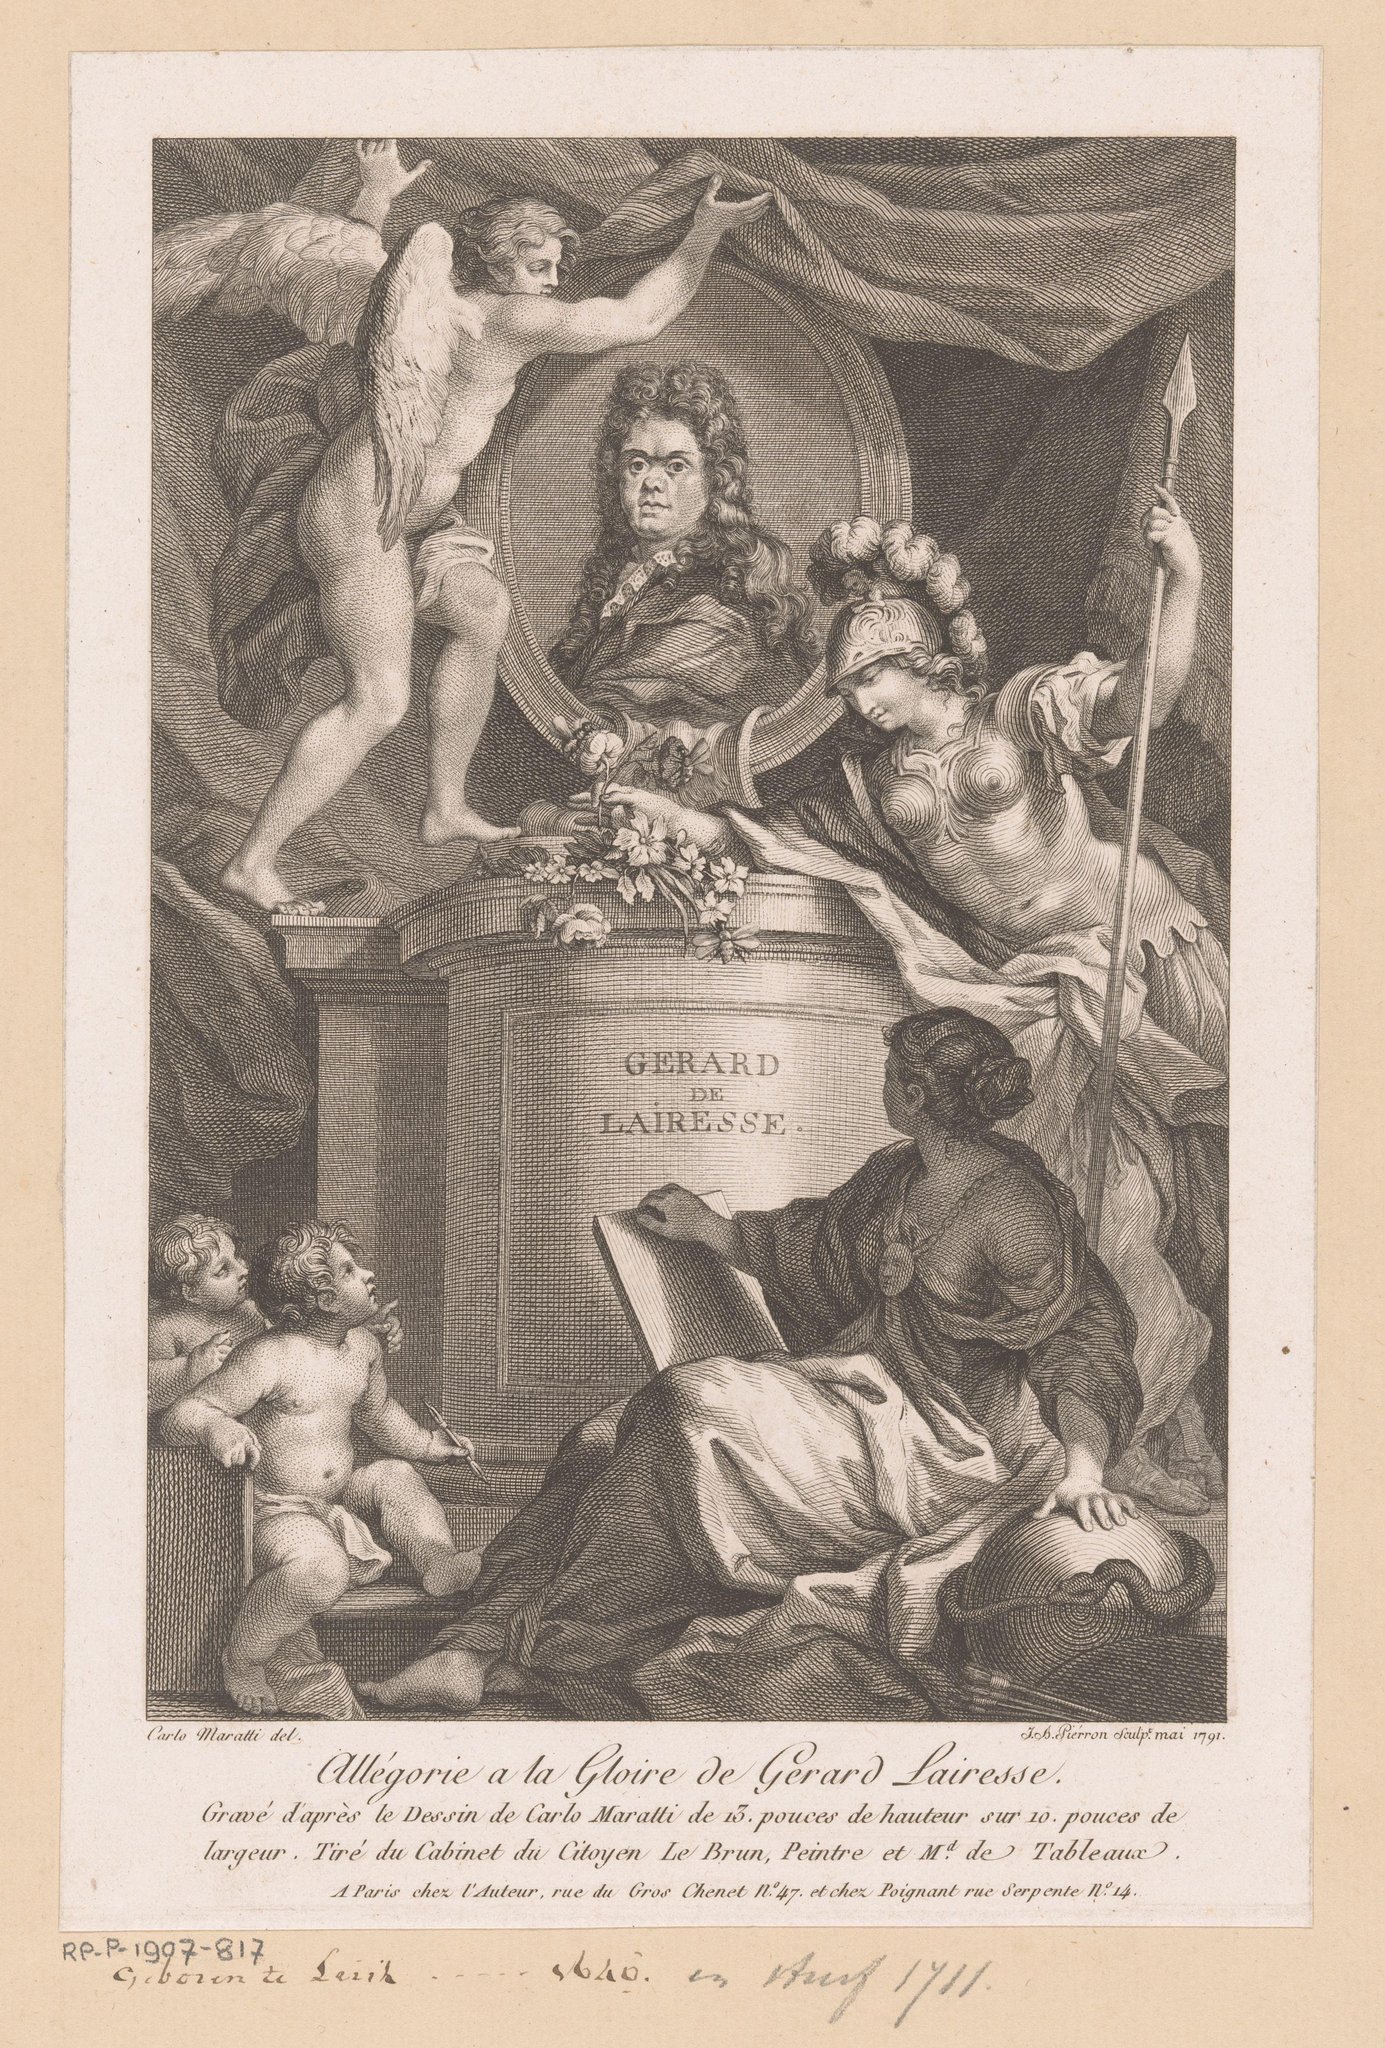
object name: print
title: Allegorie op Gerard de Lairesse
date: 1791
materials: paper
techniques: engraving, etching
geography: paris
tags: liège, painter, draughtsman, gerard de lairesse, (story of) minerva (pallas, athena), historical persons, portrait, self-portrait of painter, fame; 'fama', 'fama buona', 'fama chiara' (ripa)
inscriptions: collector's mark: Lugt 2228